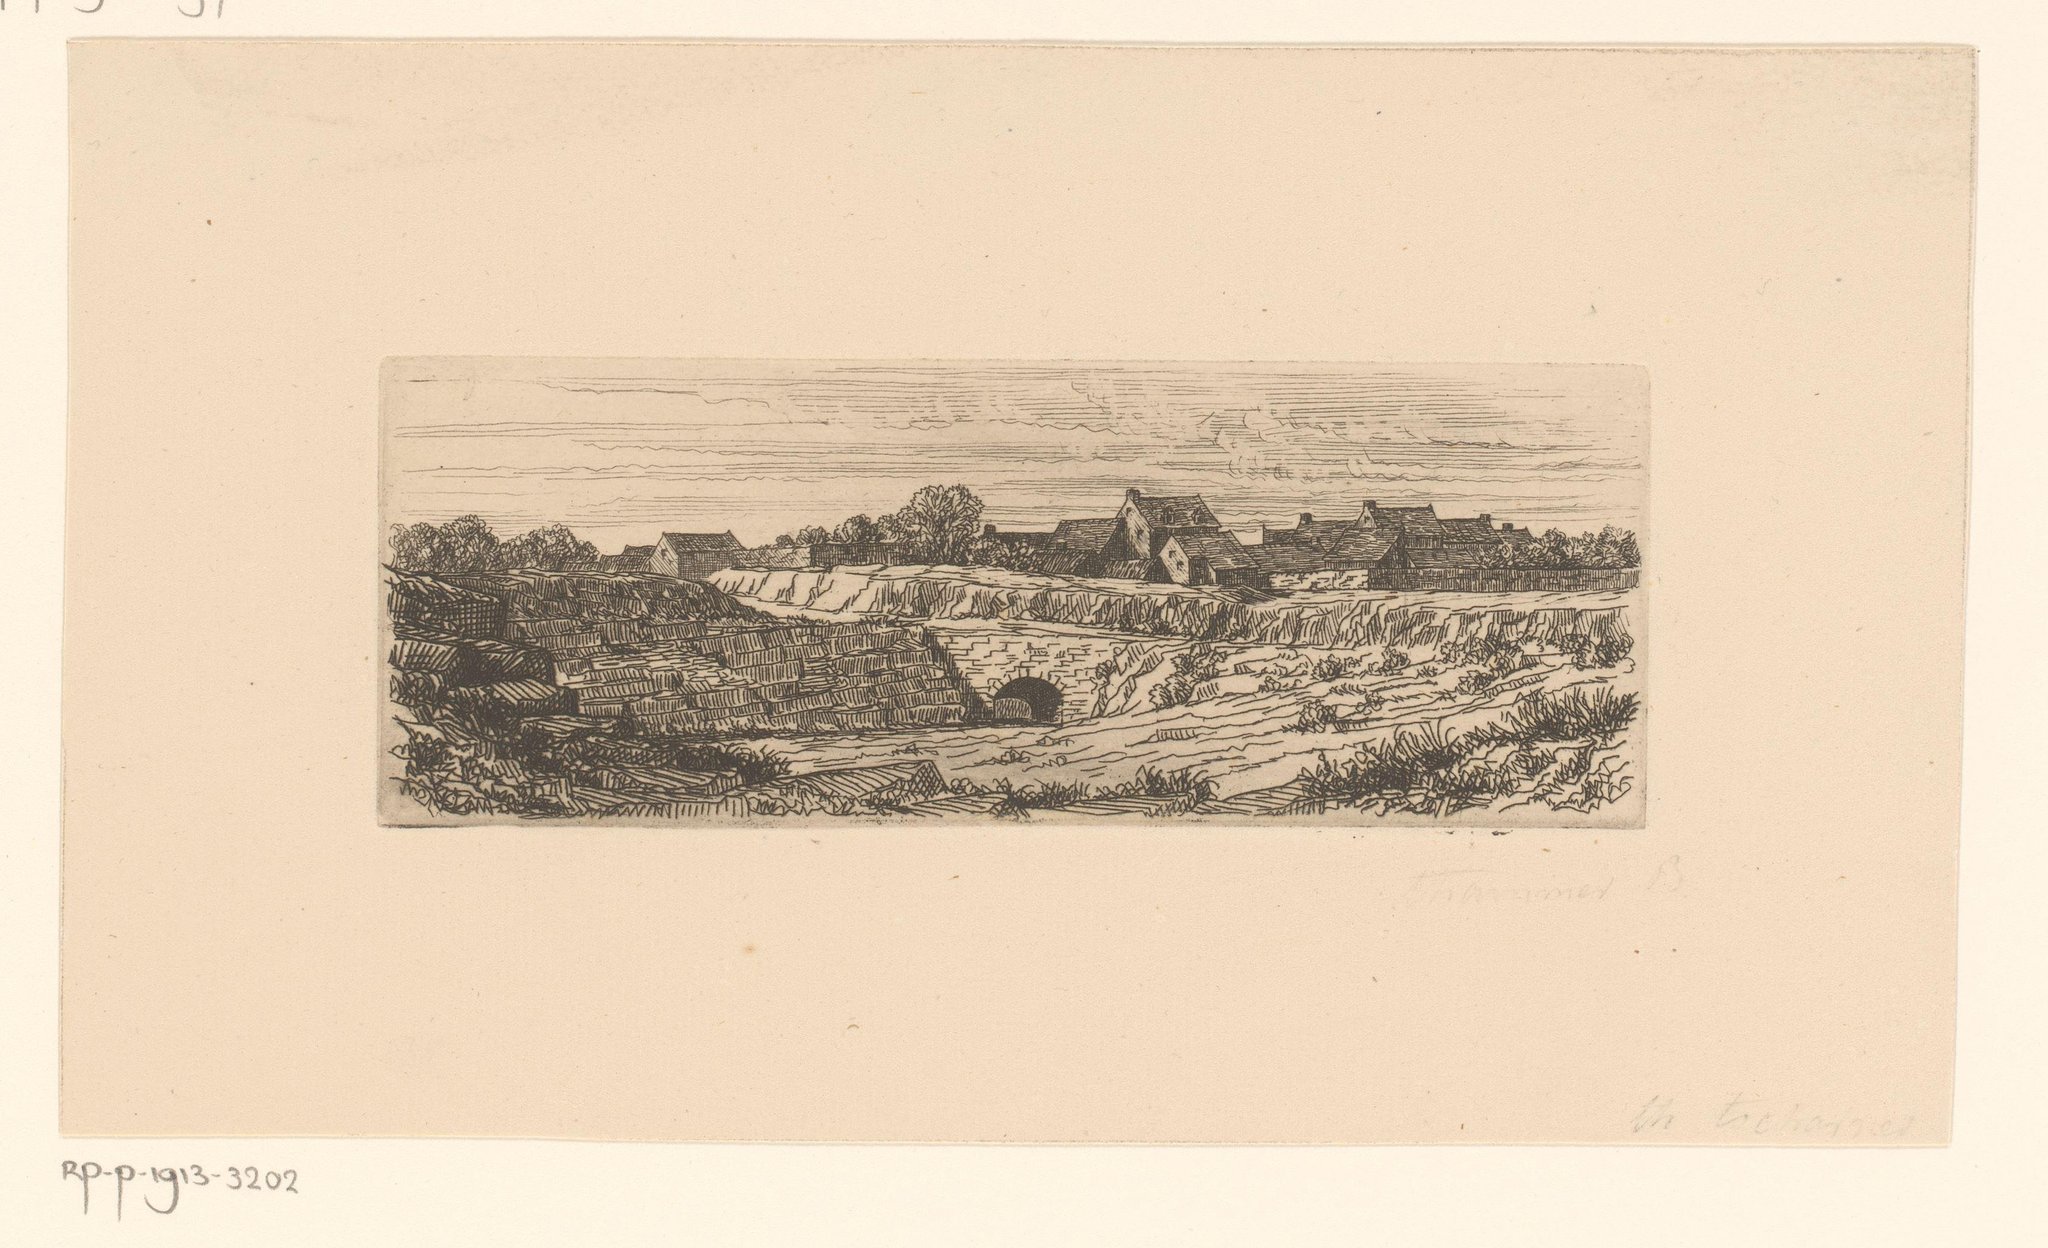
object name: print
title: Dorpsgezicht achter wallen van een fortificatie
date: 1875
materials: paper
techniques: etching, intaglio, retroussage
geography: brussels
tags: prospect of village, silhouette of village, fortifications, military engineering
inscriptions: collector's mark: Lugt 2228